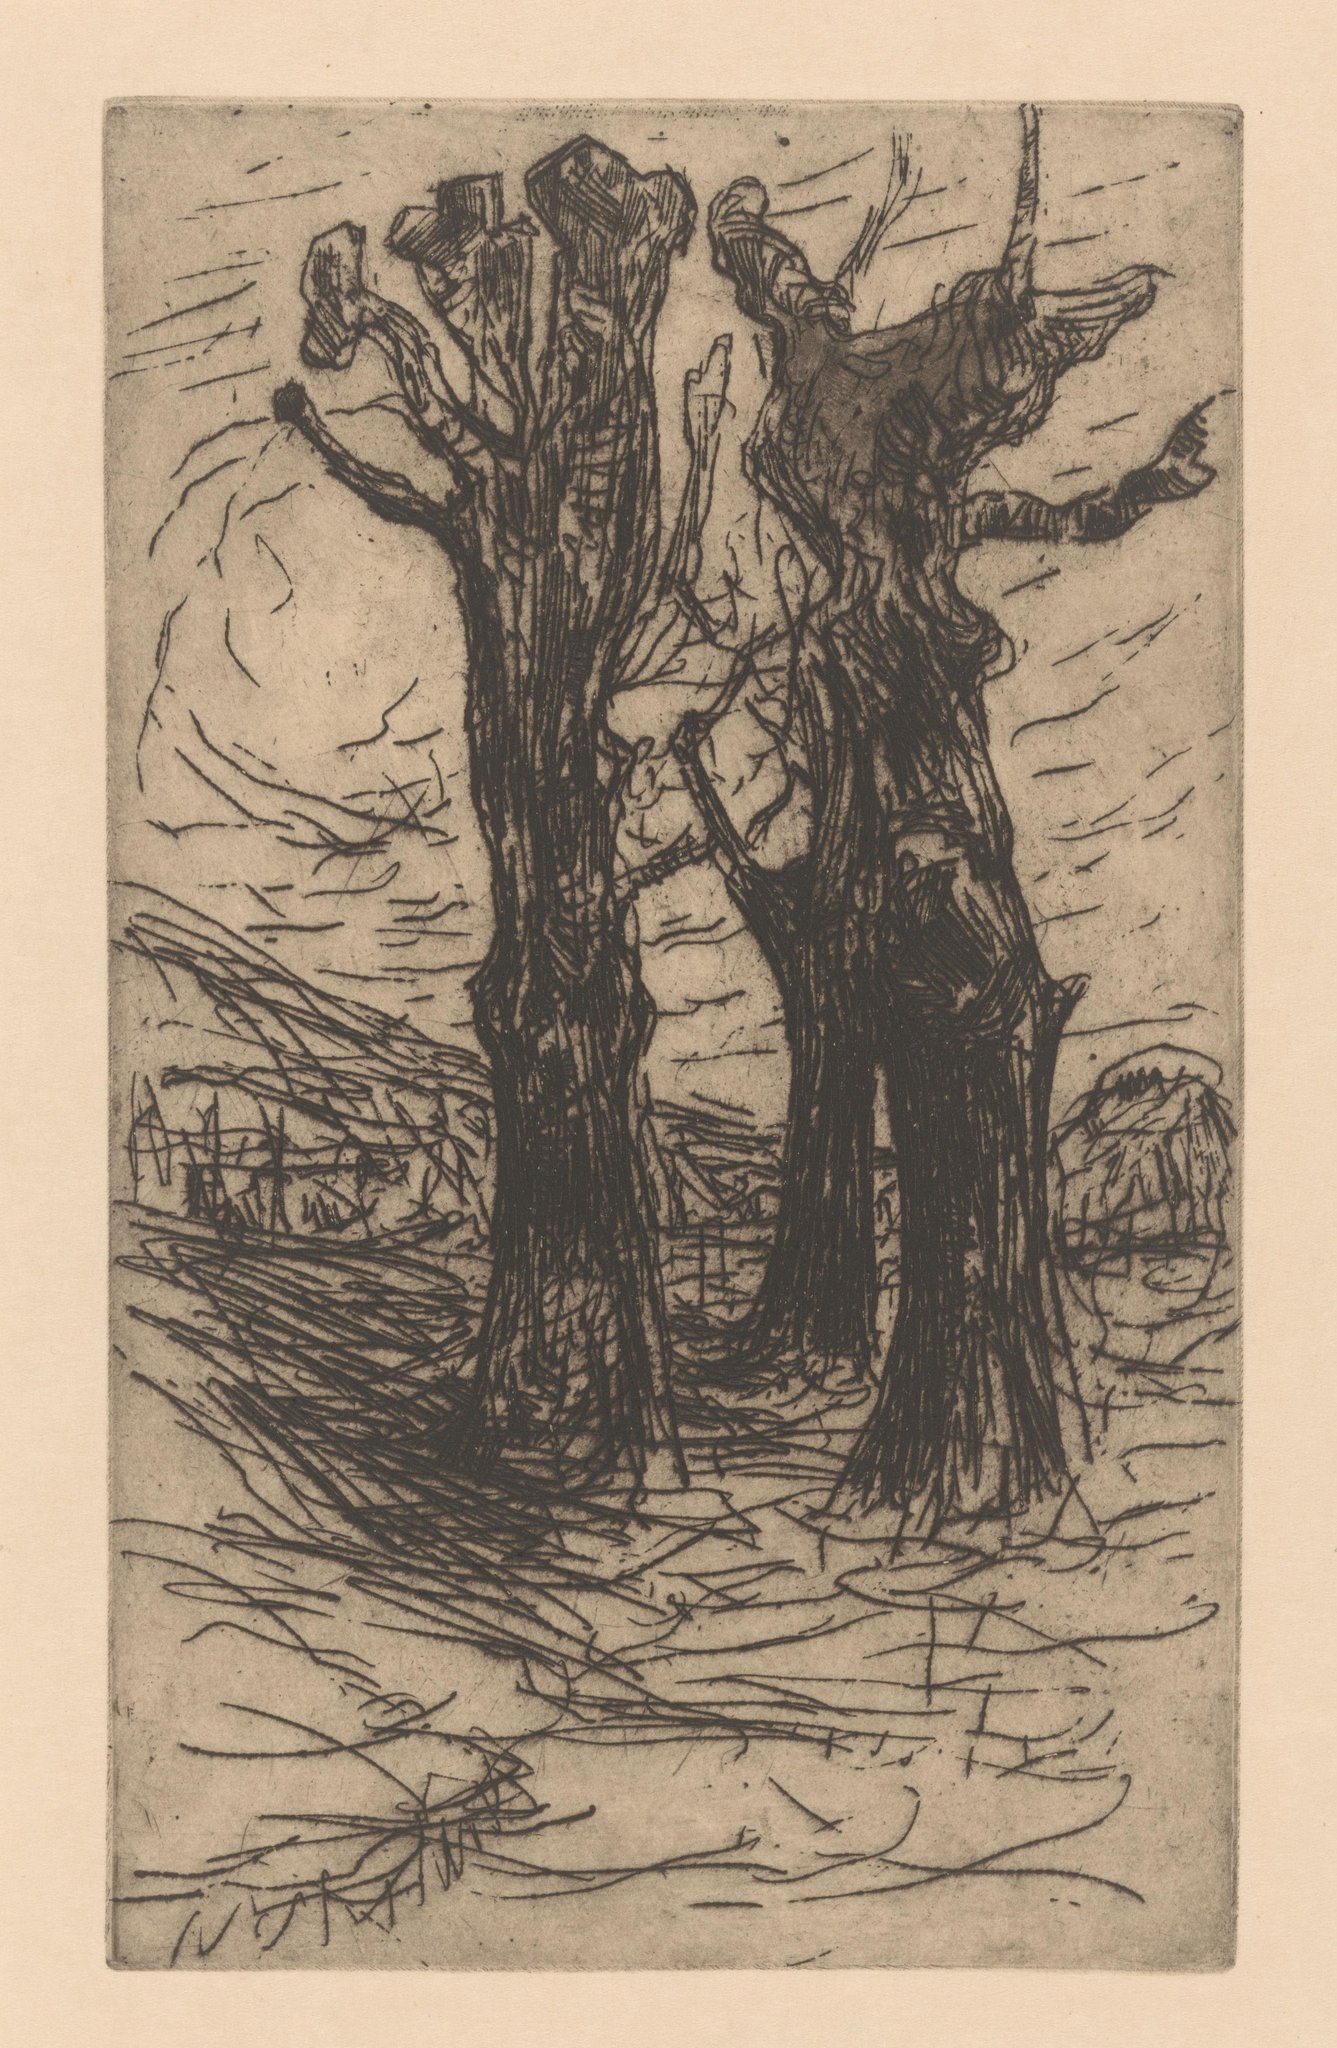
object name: print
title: Kastanjebomen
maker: floris verster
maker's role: draughtsman, painter, print maker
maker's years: 1861-1927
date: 1890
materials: paper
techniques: etching, intaglio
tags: fruits: chestnut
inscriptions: collector's mark: Lugt 2228